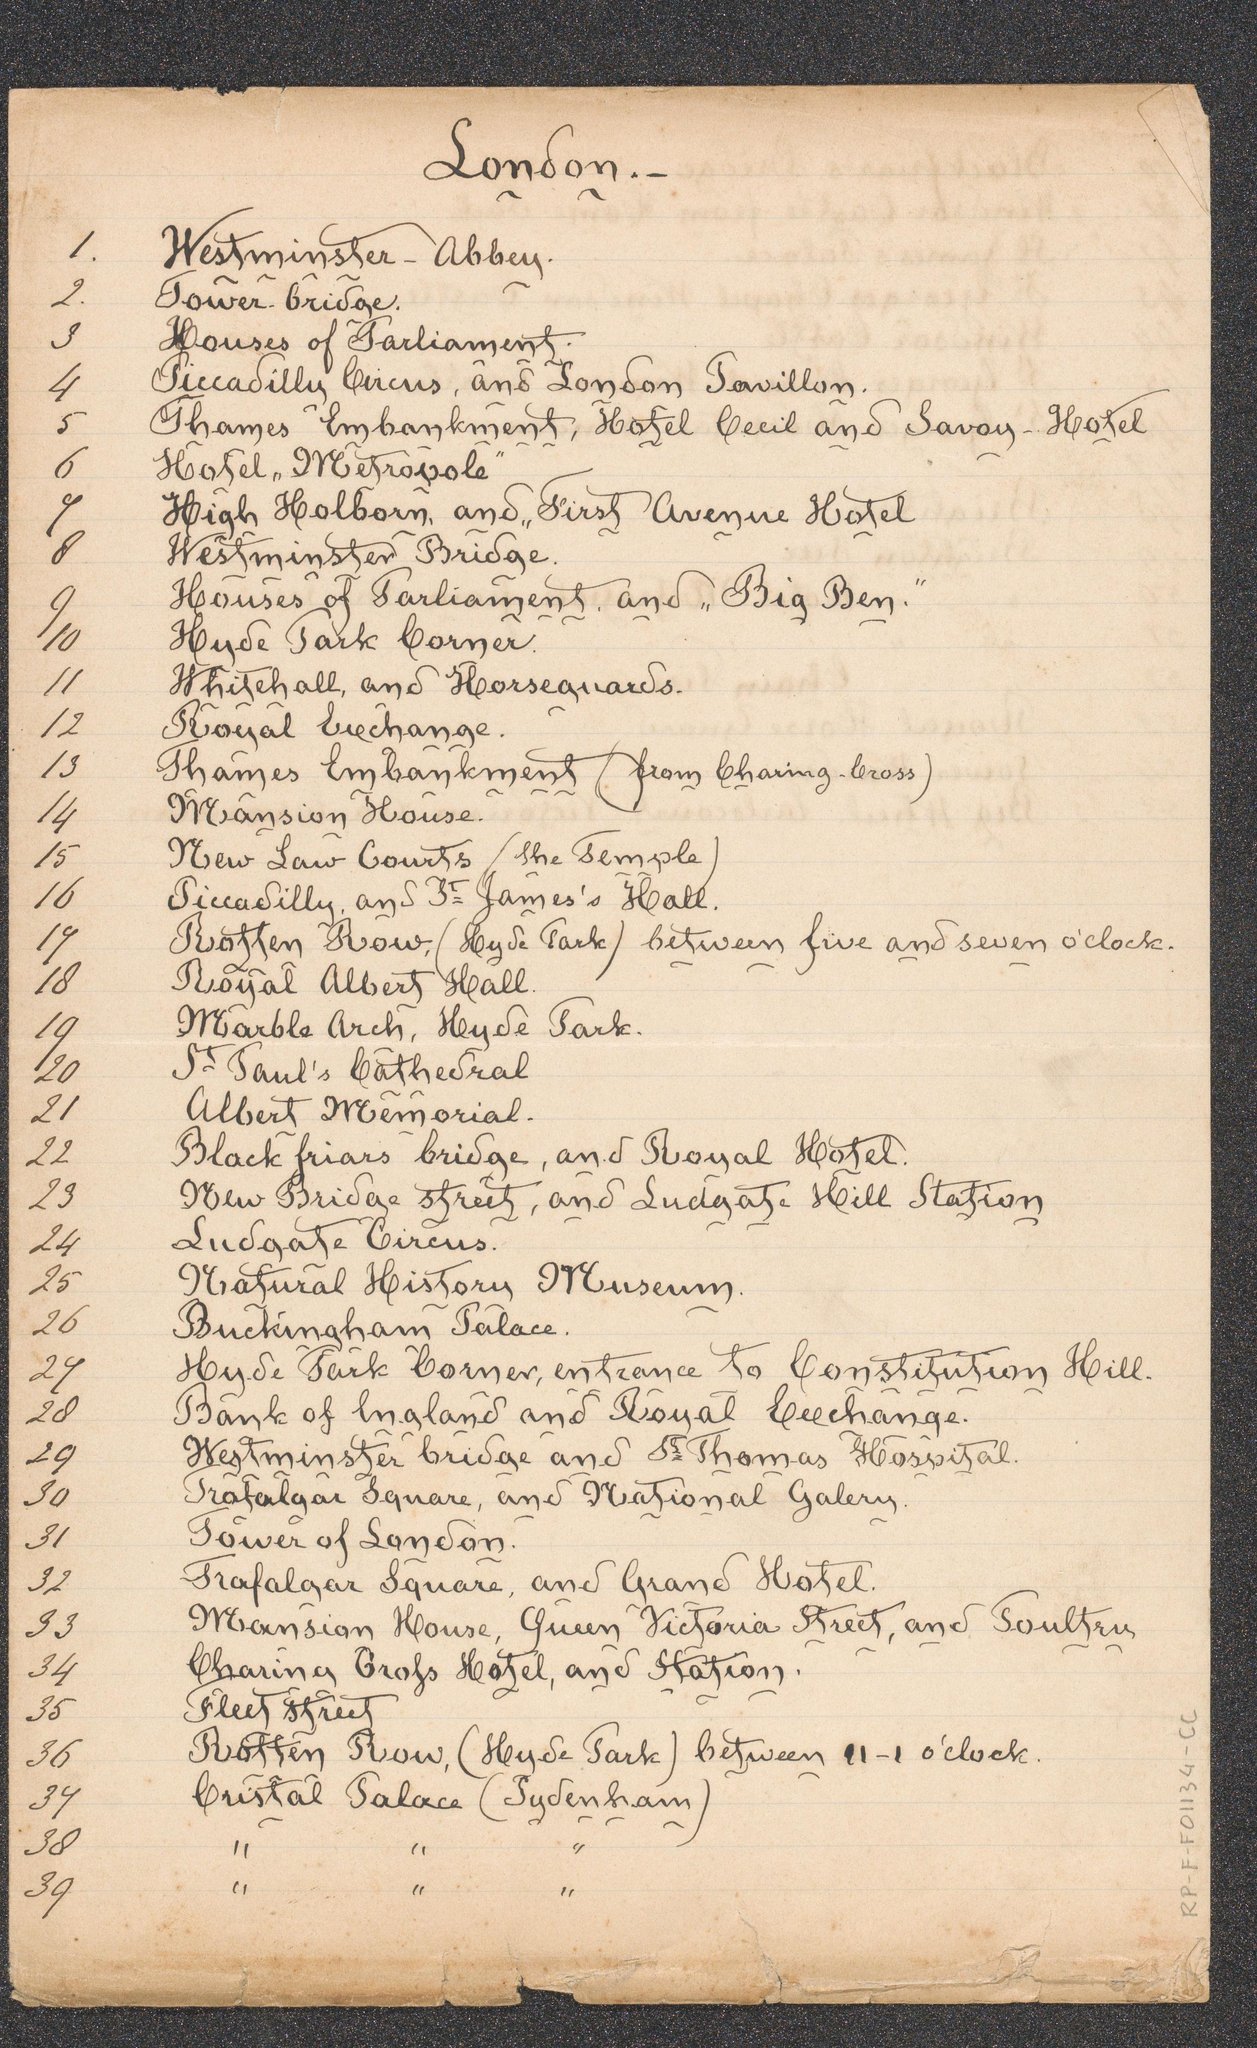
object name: list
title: Lijst met in het album afgebeelde onderwerpen in Londen, Brighton en Windsor (1 t/m 39)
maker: Anonymous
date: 1880-1910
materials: paper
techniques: writing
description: Onderdeel van Reisalbum met bezienswaardigheden in Engeland, Zwitserland, Frankrijk en Duitsland.